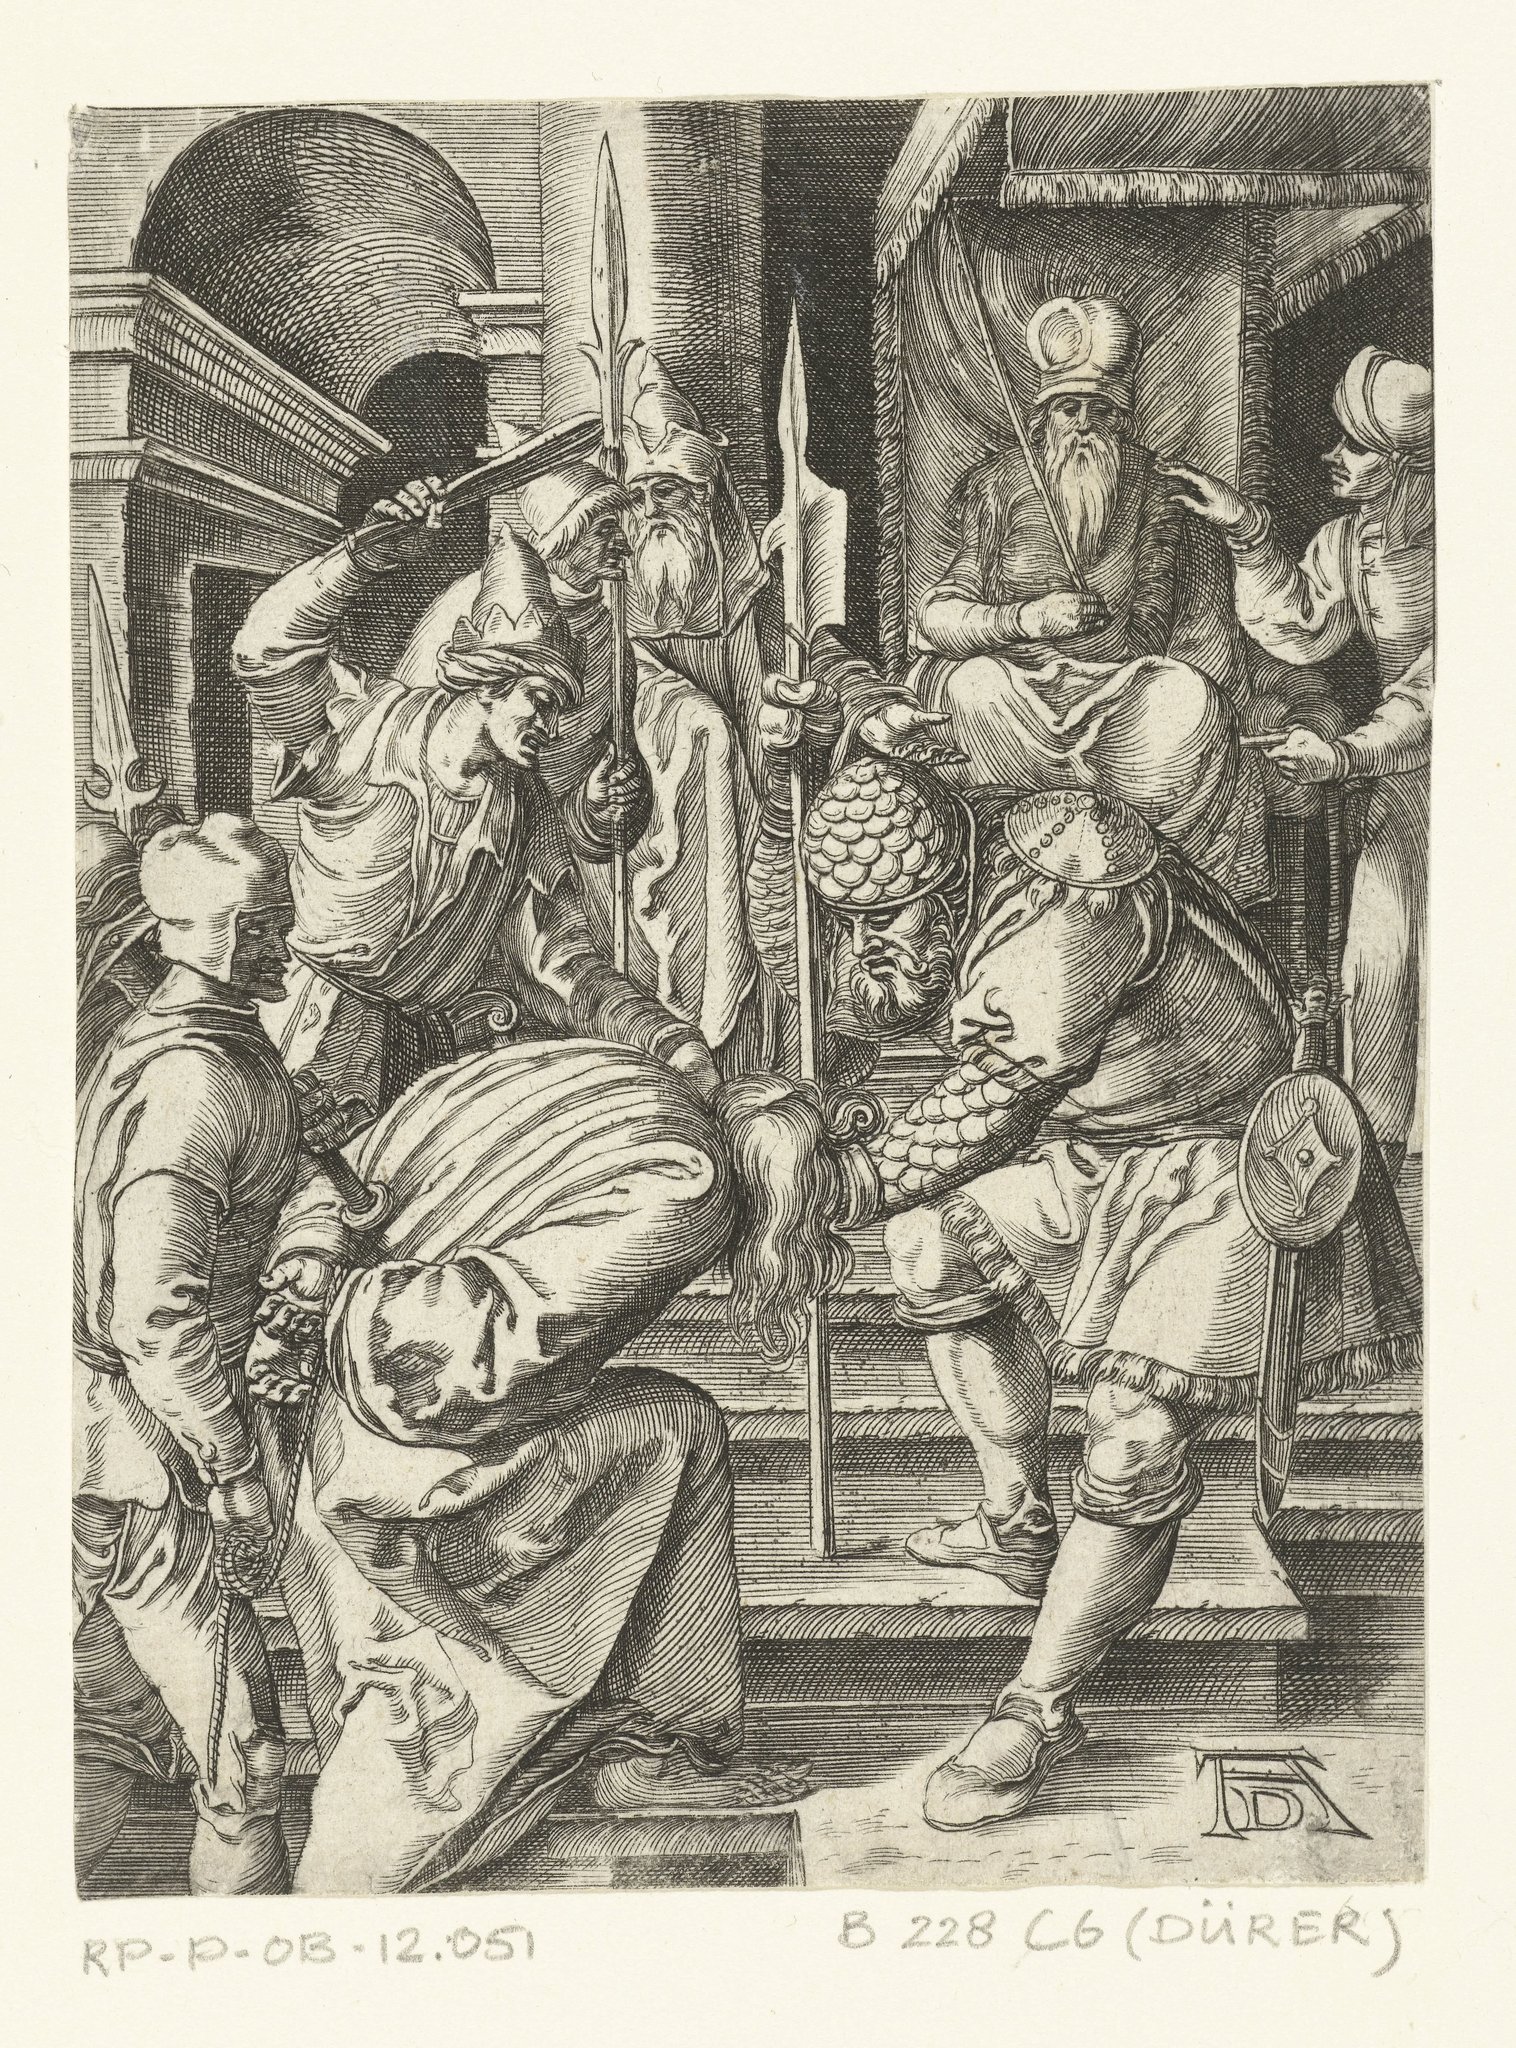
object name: print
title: Passie van Christus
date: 1510-1699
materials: paper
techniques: engraving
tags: christ before annas (hanna); maybe a soldier about to strike christ (john 18:13, 18:19-24)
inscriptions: collector's mark: Lugt 12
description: Prent naar houtsnede van Albrecht Dürer uit een serie van zevenendertig prenten met als onderwerp het levensverhaal van Christus, bekend als Passie van Christus. Illustratie gebruikt voor: Passio Christi ab Alberto Durer Nurenburgensi effigiata, Abraham van Waesberge (uitgever).